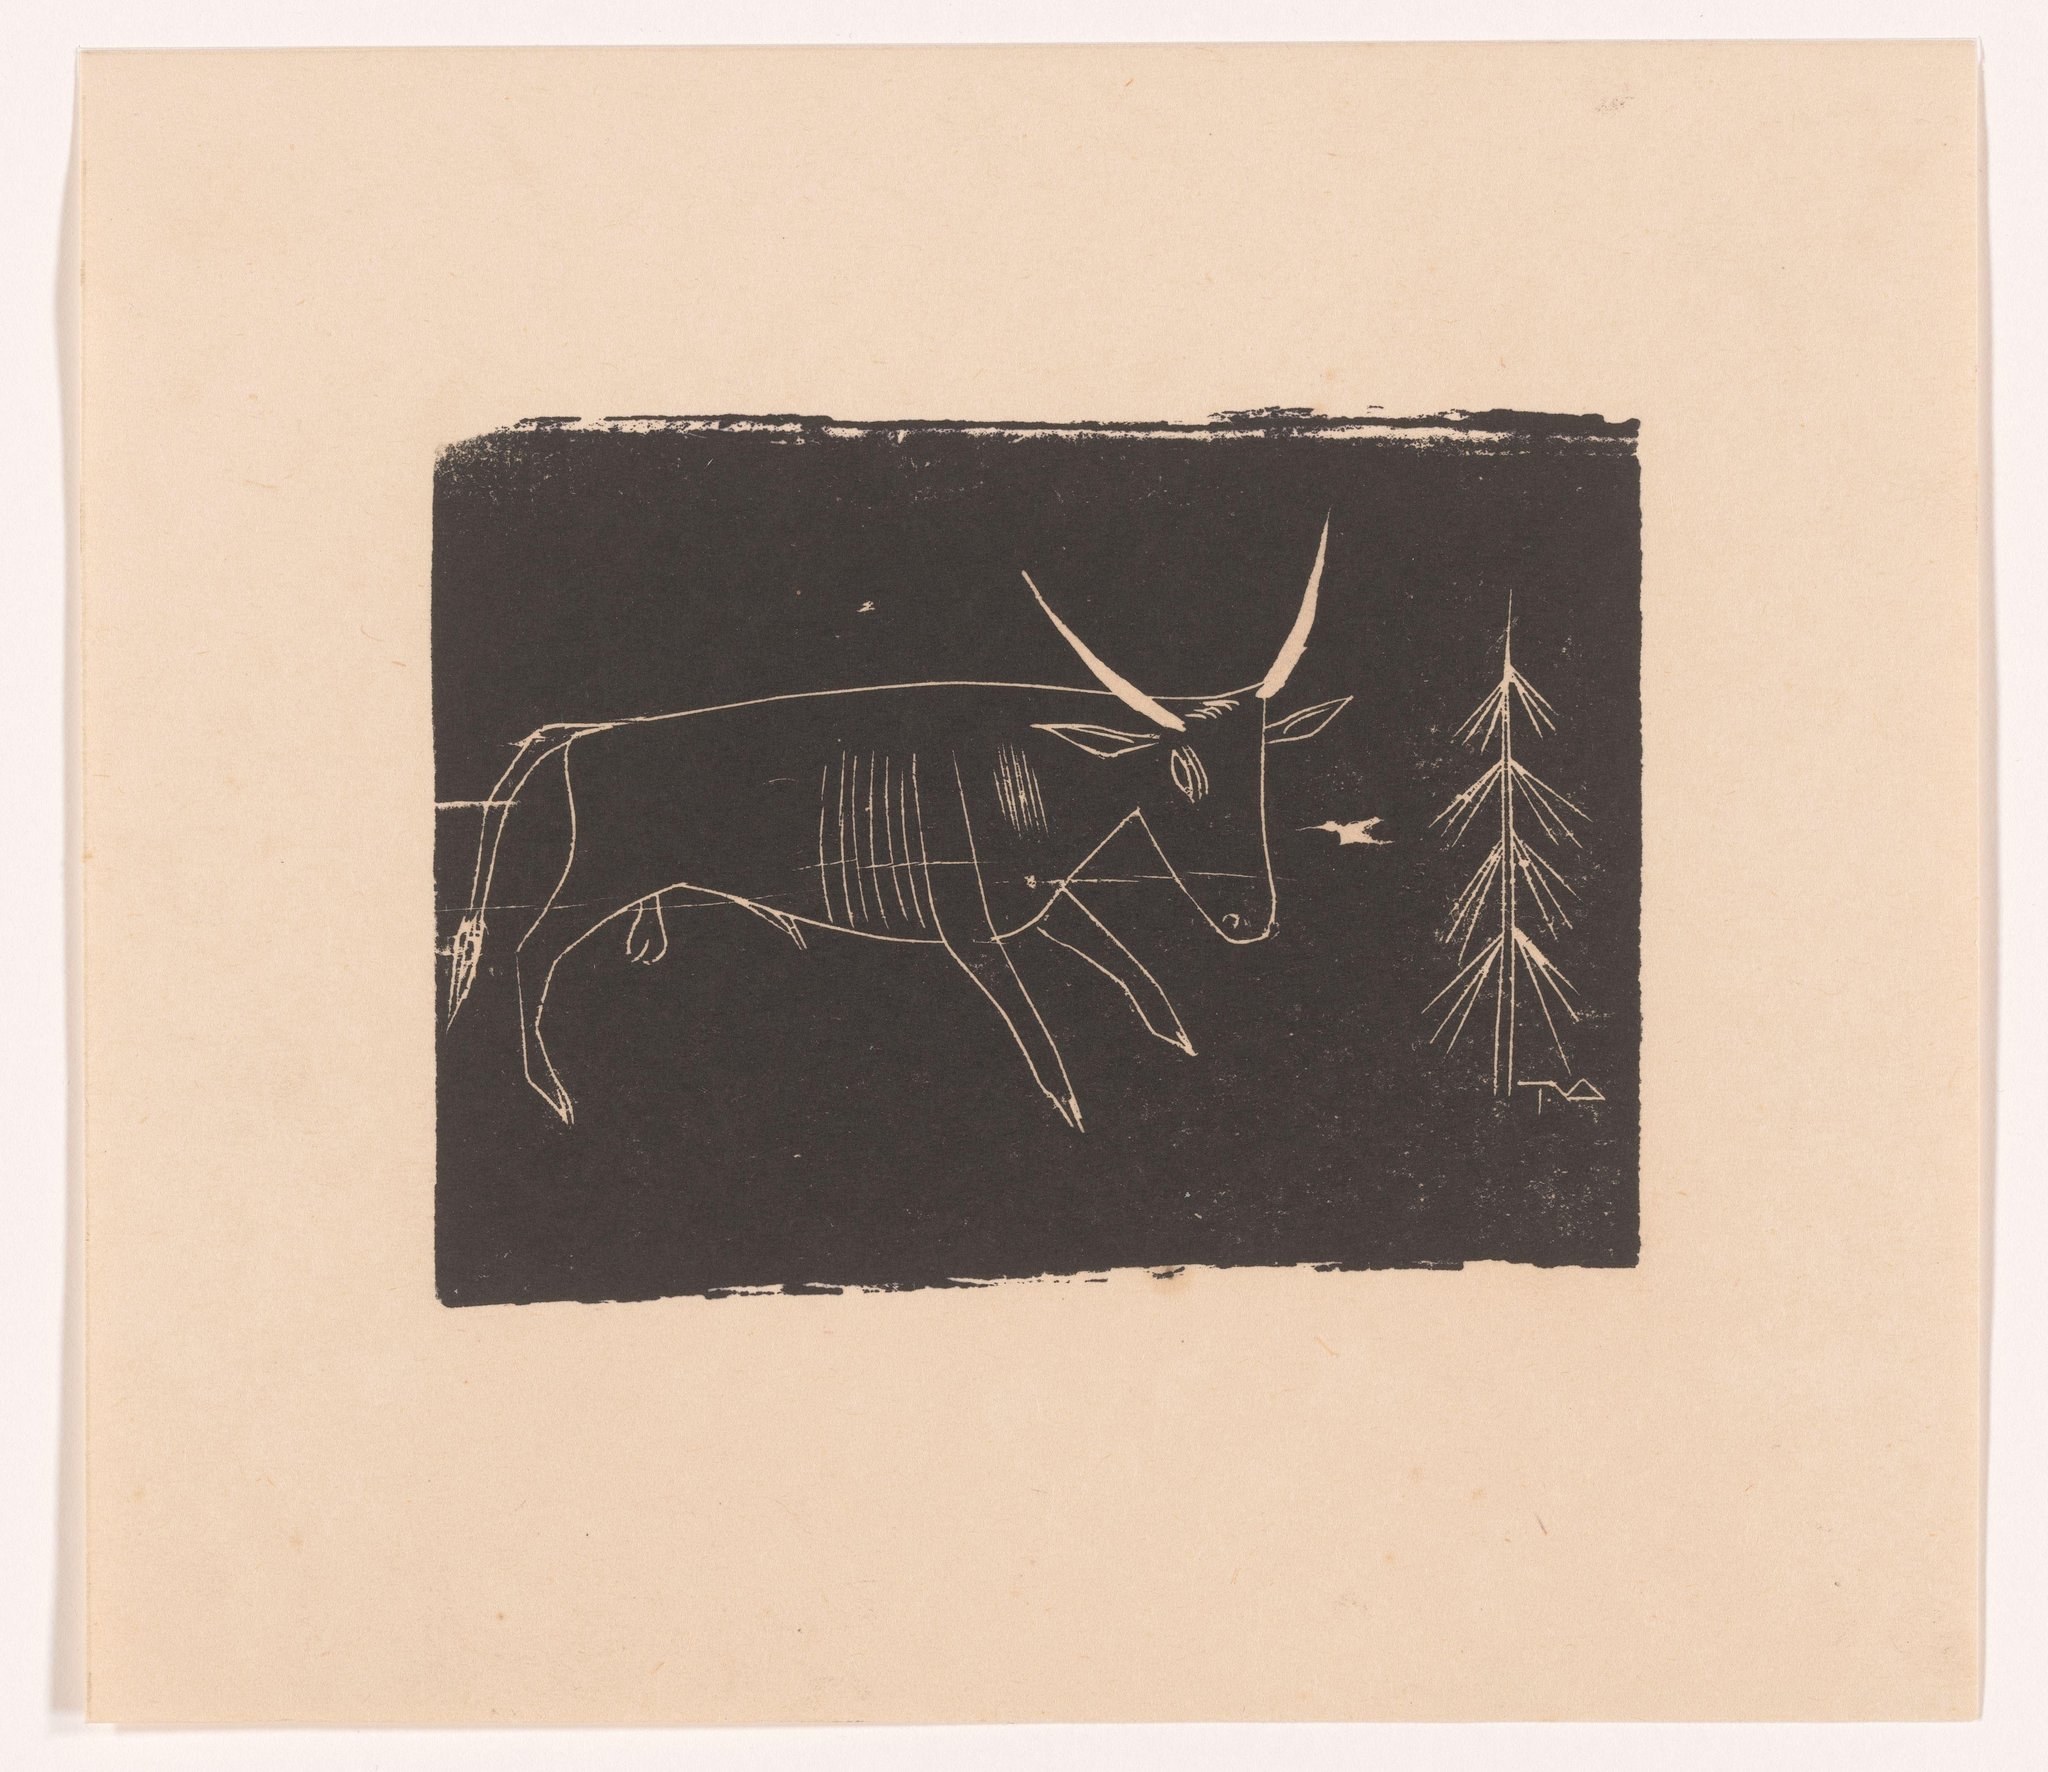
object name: print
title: Stier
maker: tinus van doorn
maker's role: painter, print maker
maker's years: 1905-1940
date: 1920-1940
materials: paper, ink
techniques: linocut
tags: bull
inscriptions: monogram: ‘TVD’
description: Stier in witte contouren tegen een zwart fond.